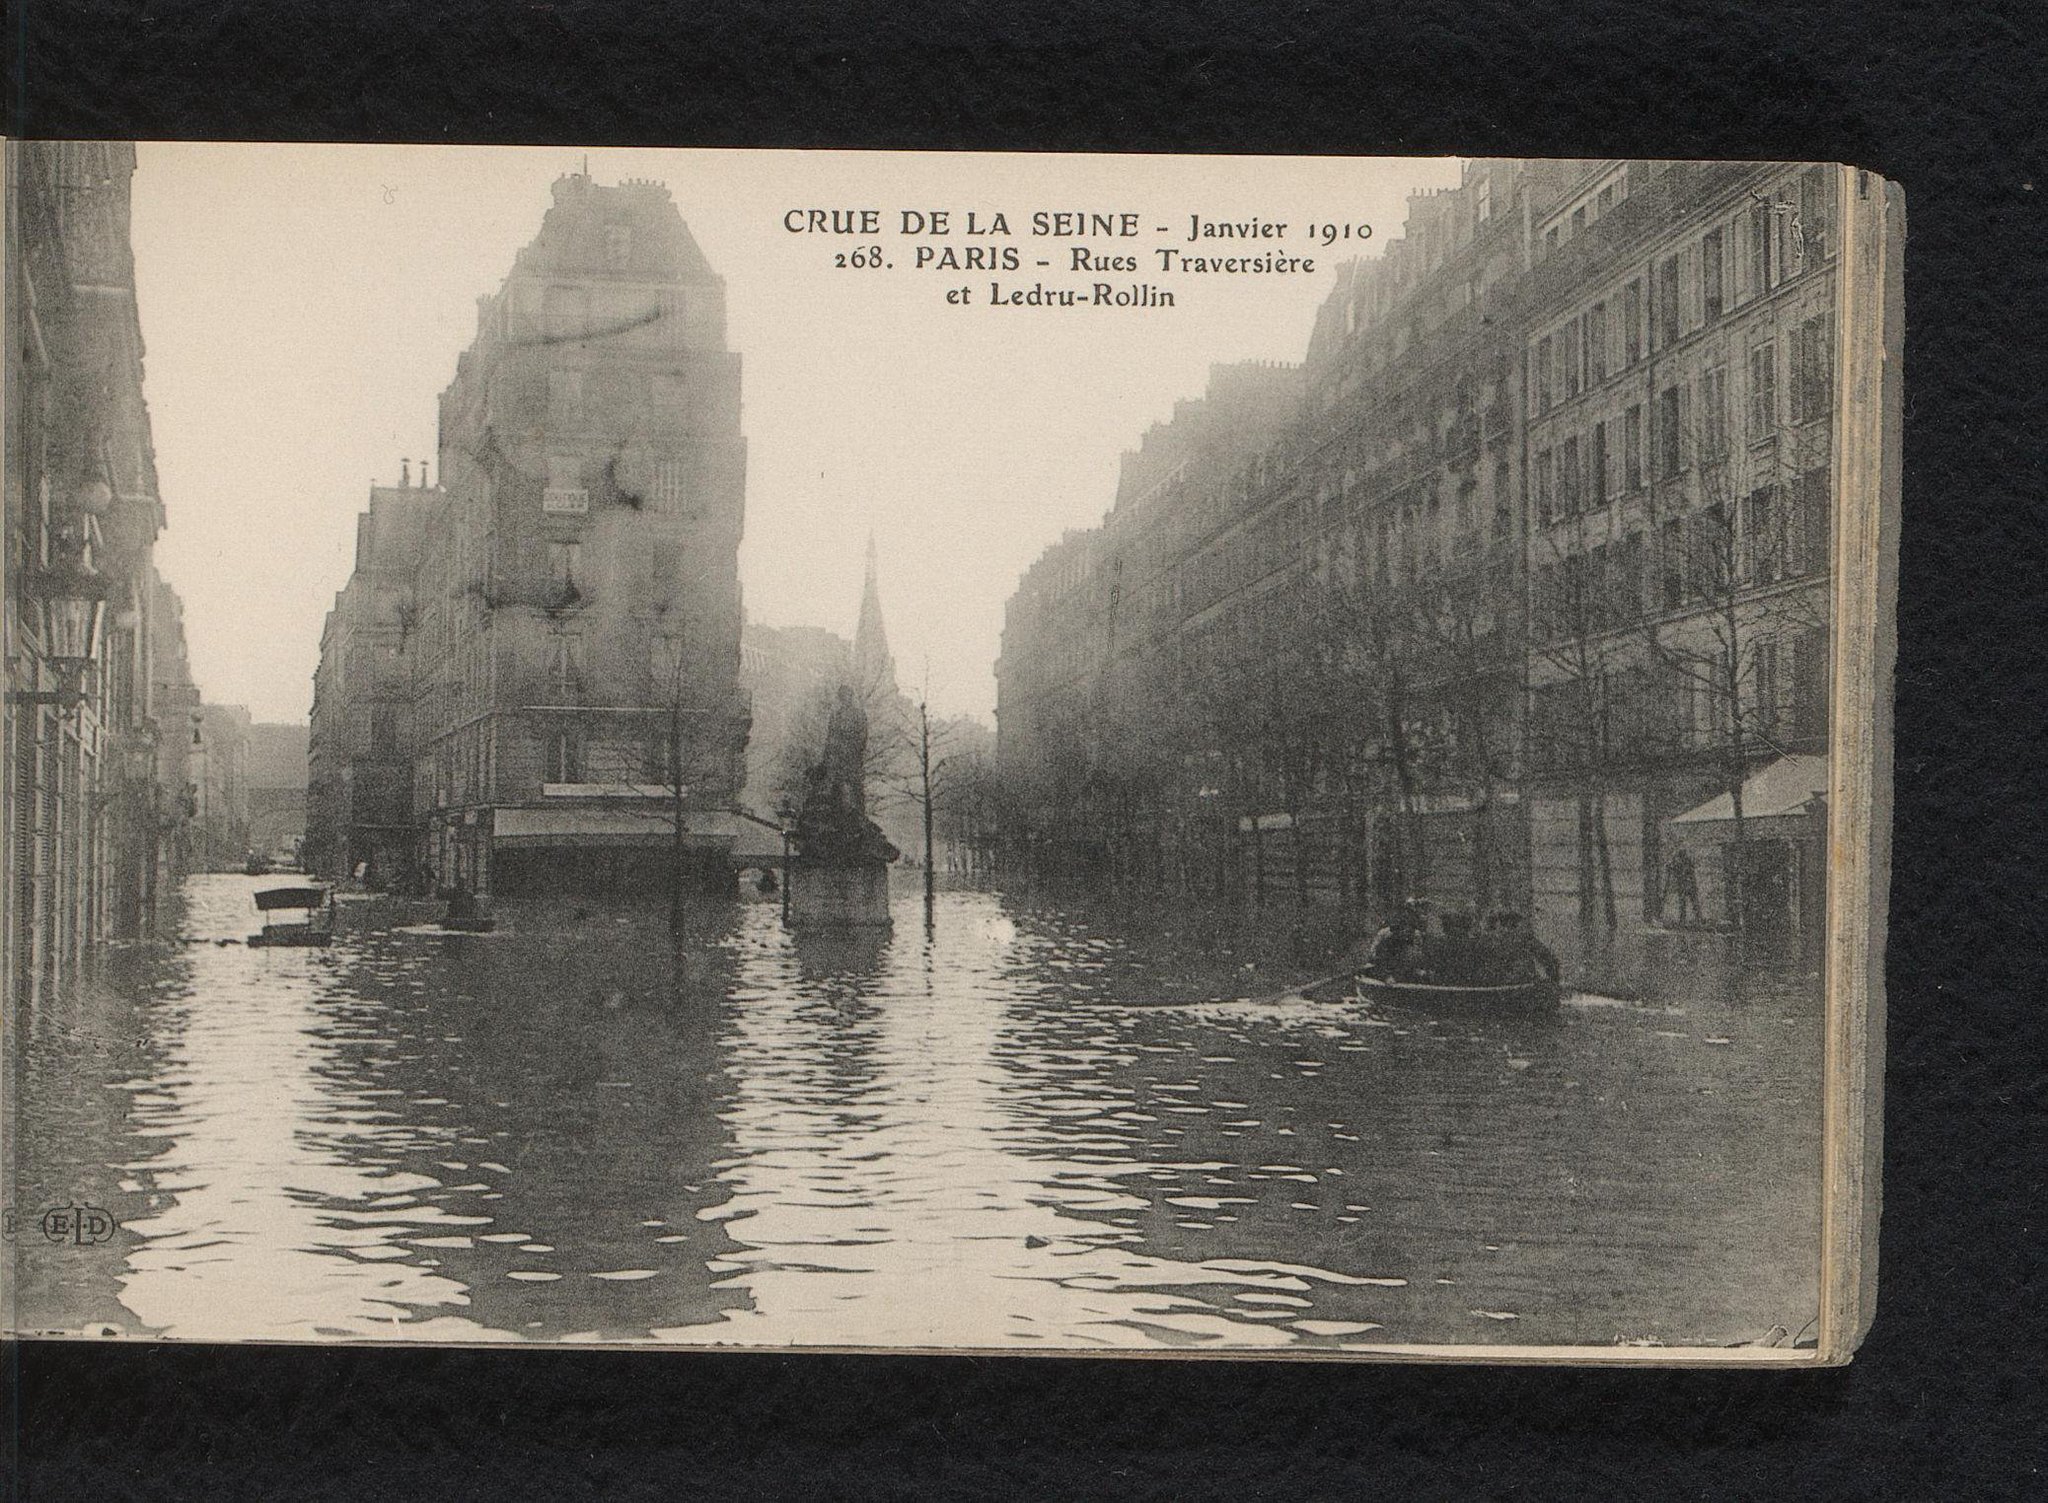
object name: ansichtkaart, prentbriefkaart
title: Crue de la Seine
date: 1910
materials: cardboard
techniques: photograph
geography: paris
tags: rowing-boat, canoe, etc., flood, city-view, and landscape with man-made constructions (+ city(-scape) with figures, staffage), paris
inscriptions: date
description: Prentbriefkaart maakt deel uit van een album.